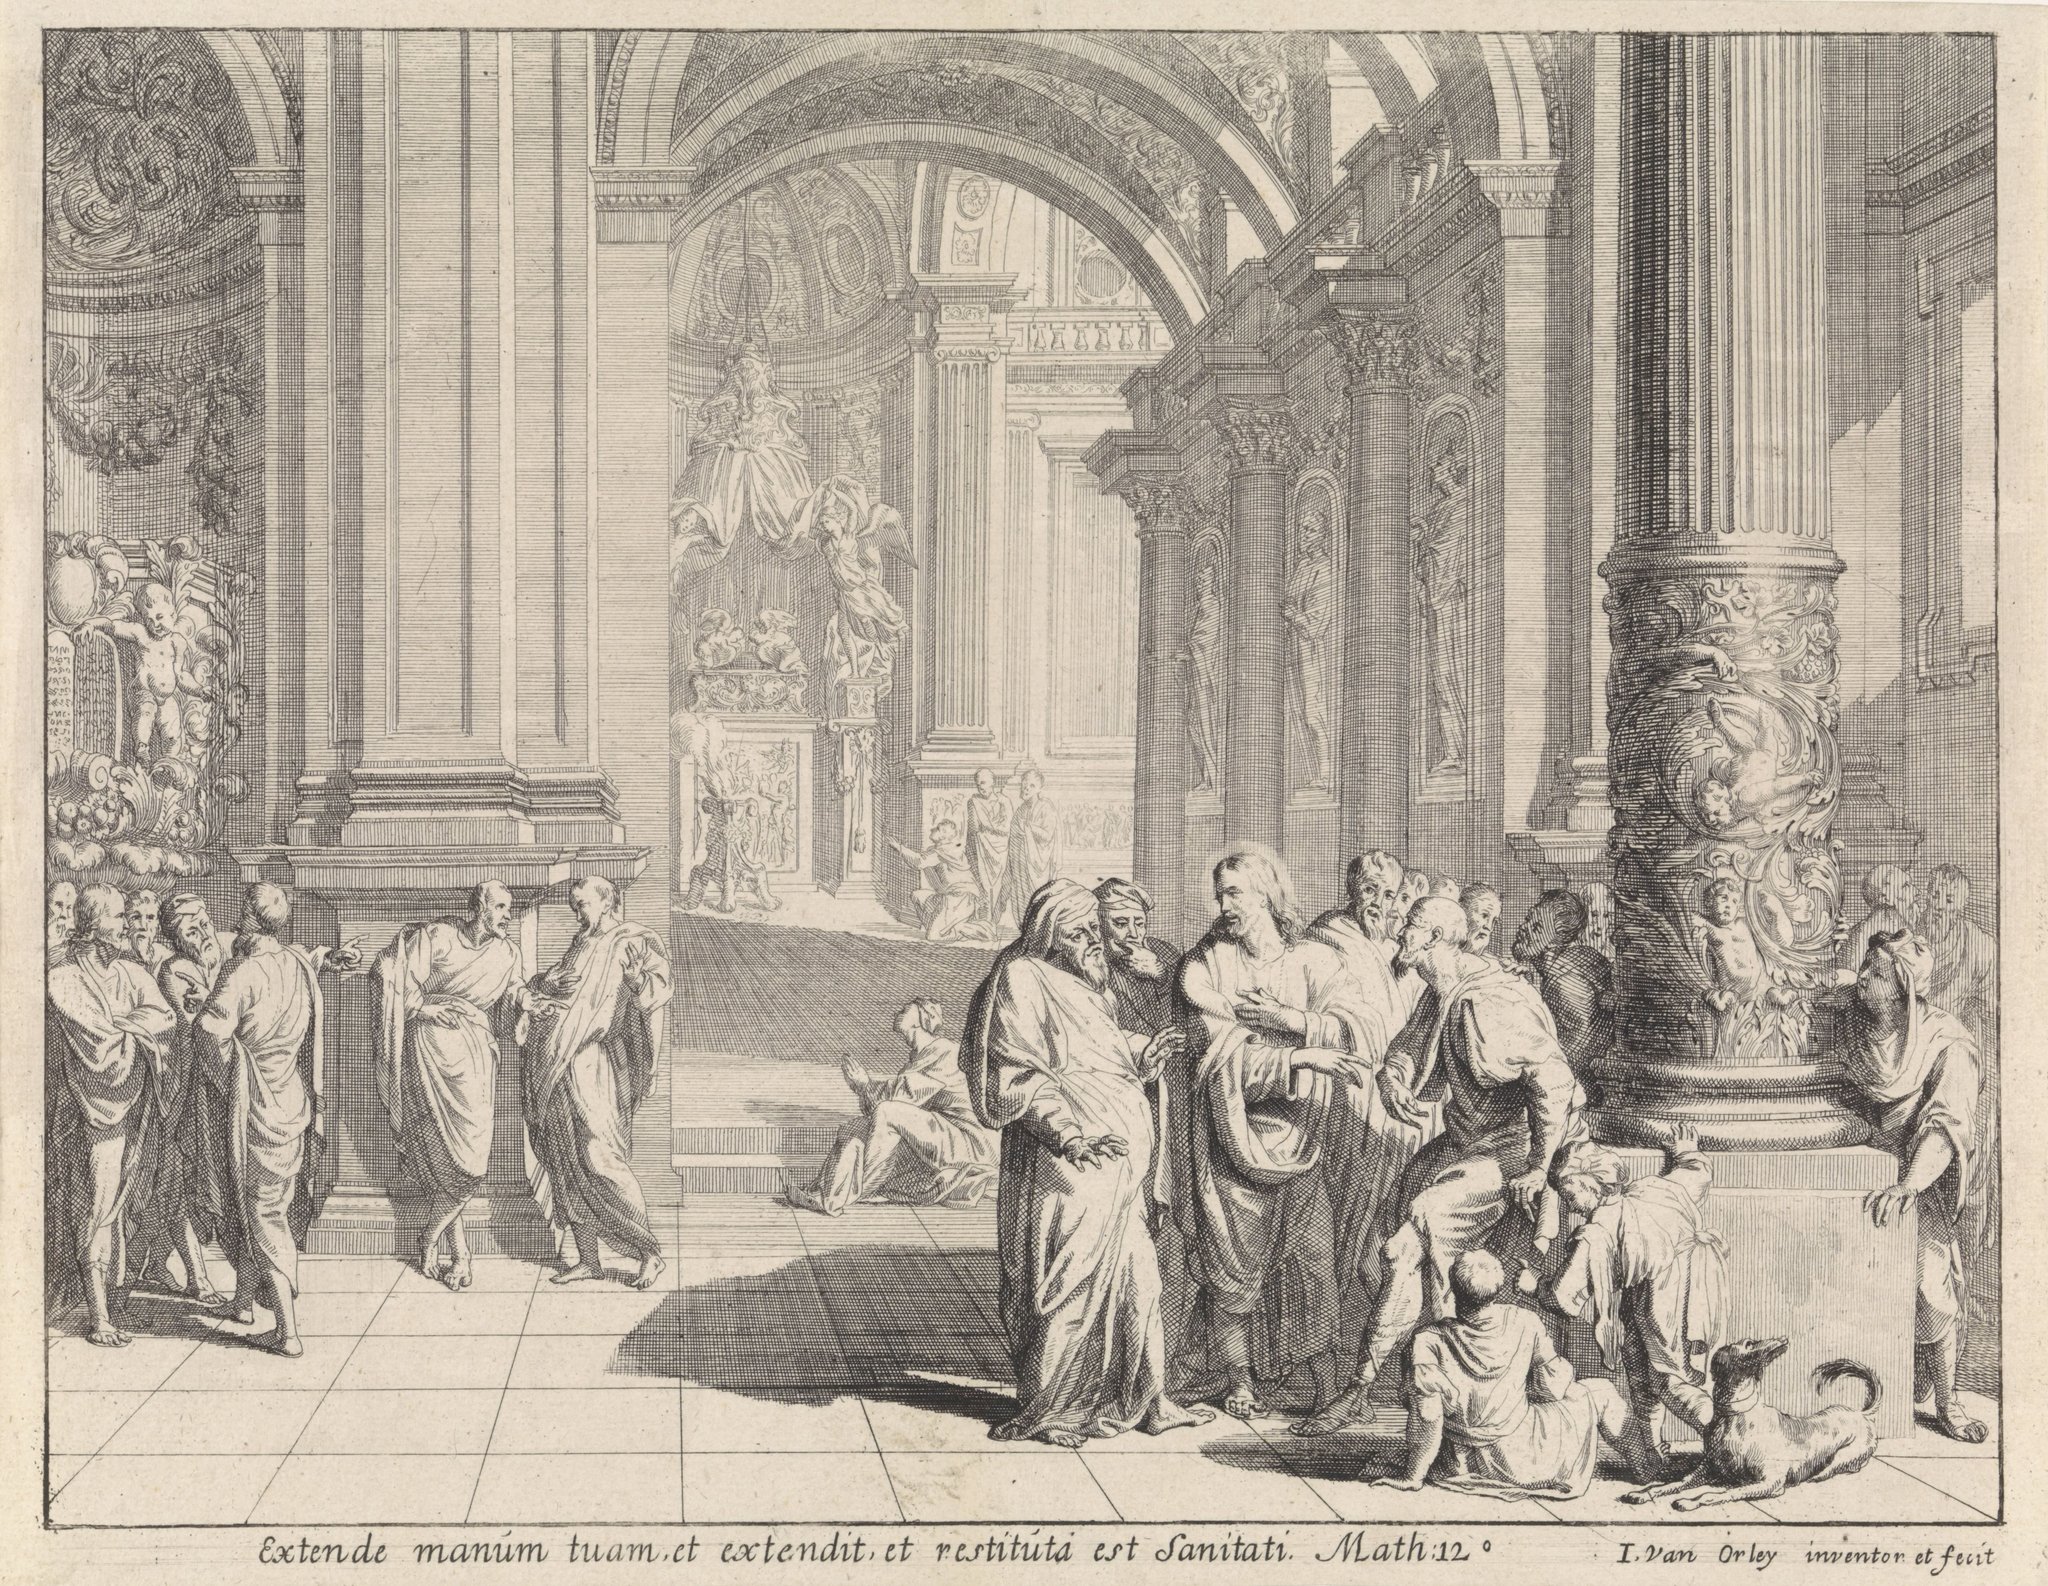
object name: print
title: Scènes uit het Nieuwe Testament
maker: jan van orley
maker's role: print maker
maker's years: 1665-1735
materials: paper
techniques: engraving, etching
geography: brussels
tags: healing of a man with a withered hand (matthew 12:9-13; mark 3:1-5; luke 6:6-10)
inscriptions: collector's mark: Lugt 240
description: Christus staat in de tempel en geneest een man met een verschrompelde hand. Een man komt bij hem om hem te vertellen dat zijn familie buiten op hem wacht. Links Christus familie die tegen gehouden wordt door een tempelbediende. Onder de afbeelding een Latijns bijbelvers uit Mat. 12.